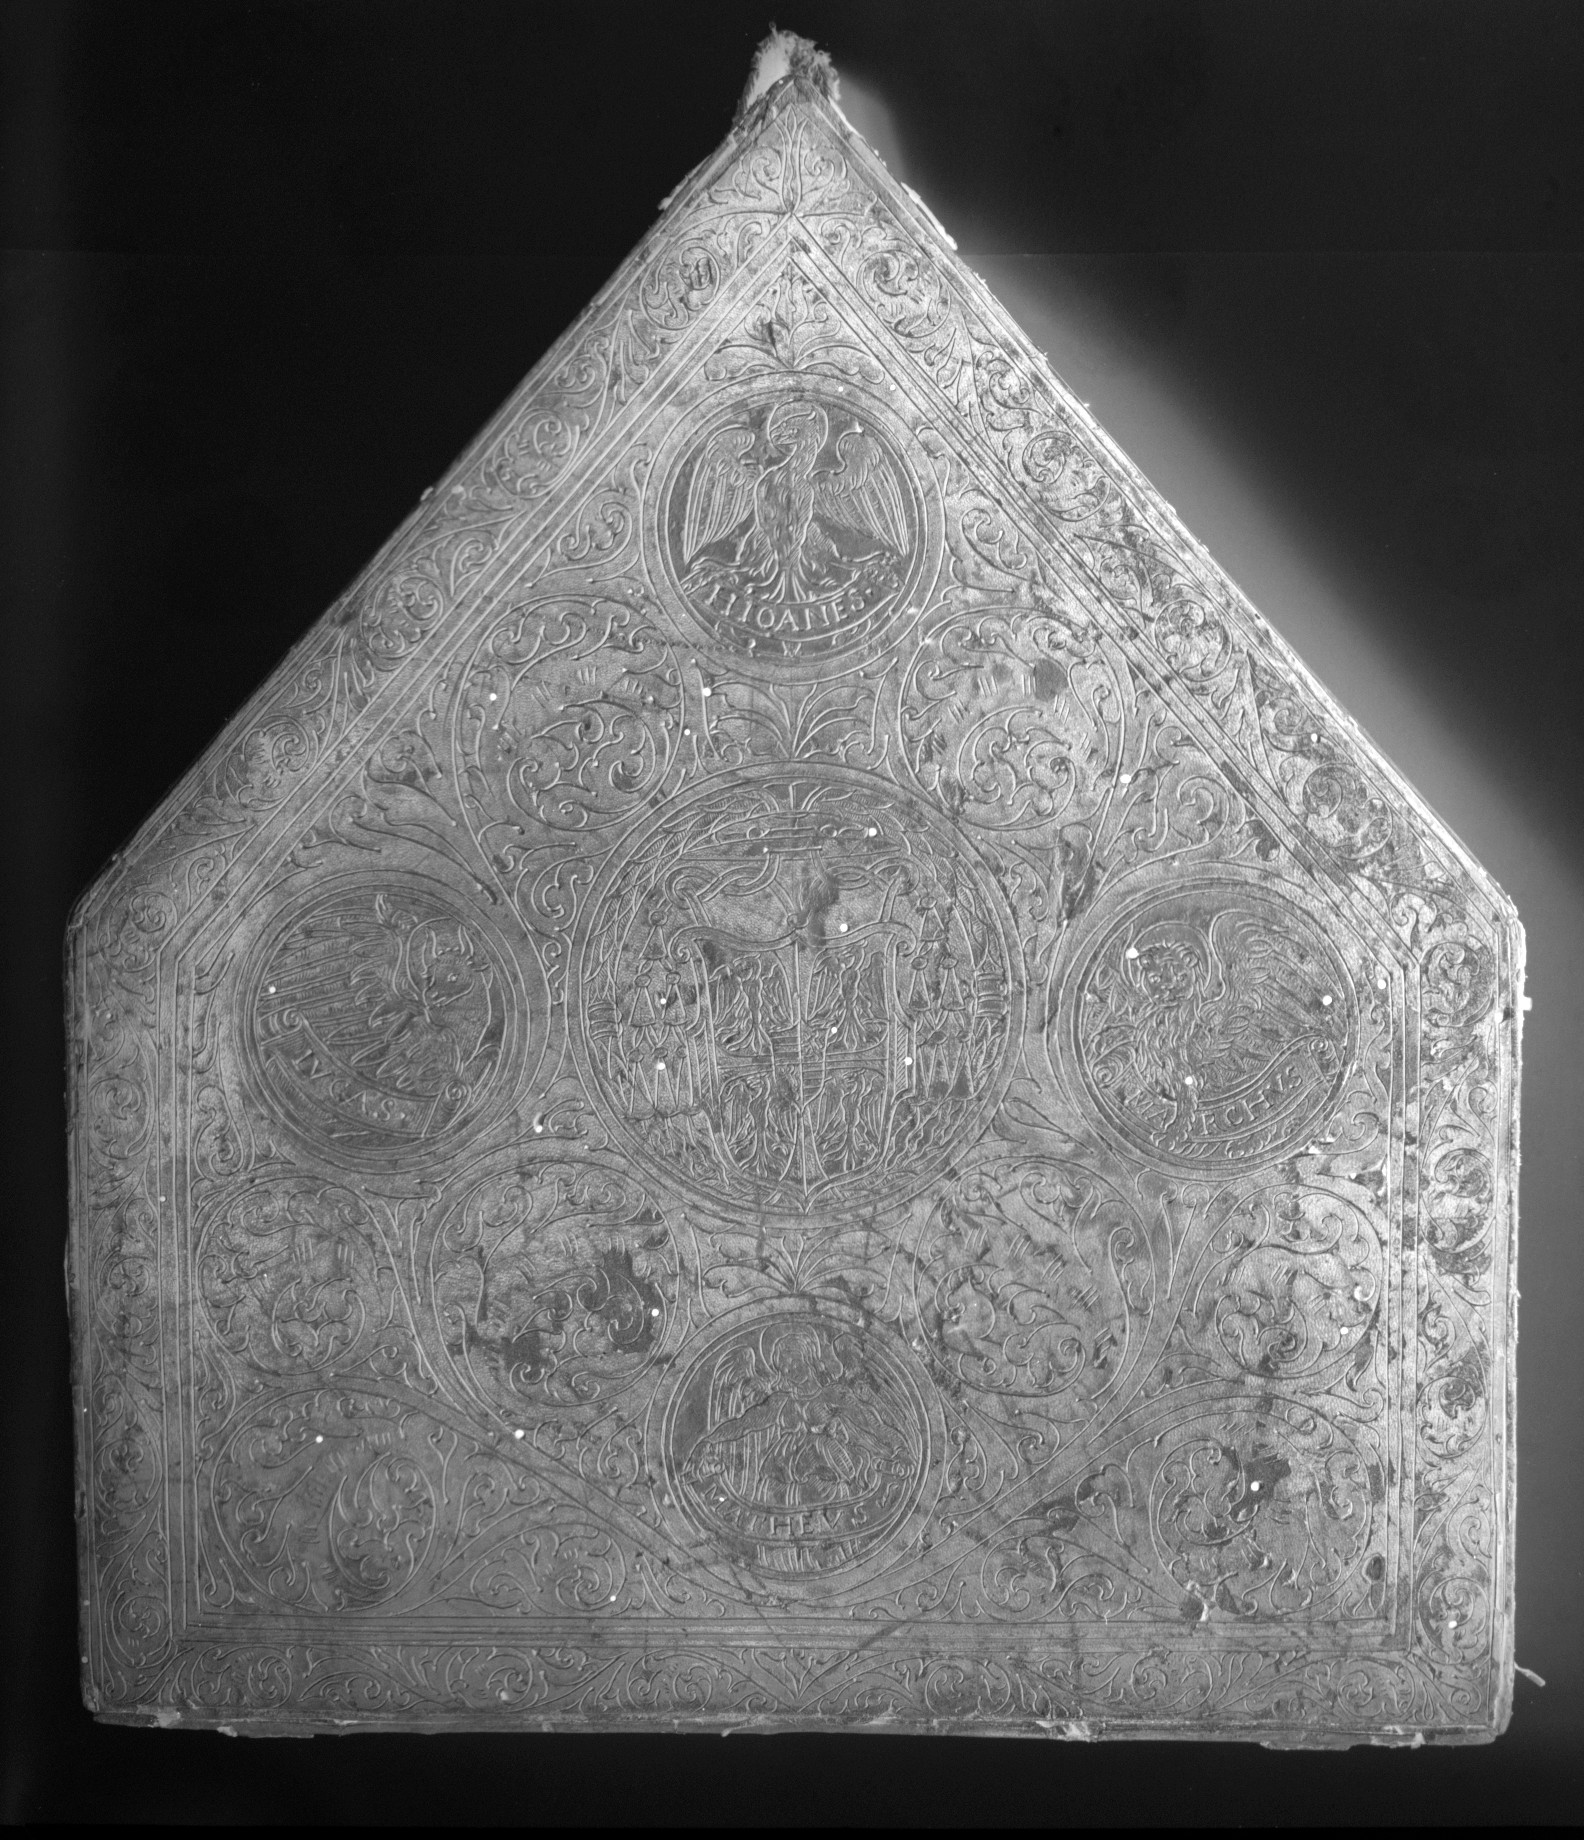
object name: mitre case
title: Mitre case with the arms of Cardinal Scipio Gonzaga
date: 1587-1593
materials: cord, leather, wood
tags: birds,coat of arms